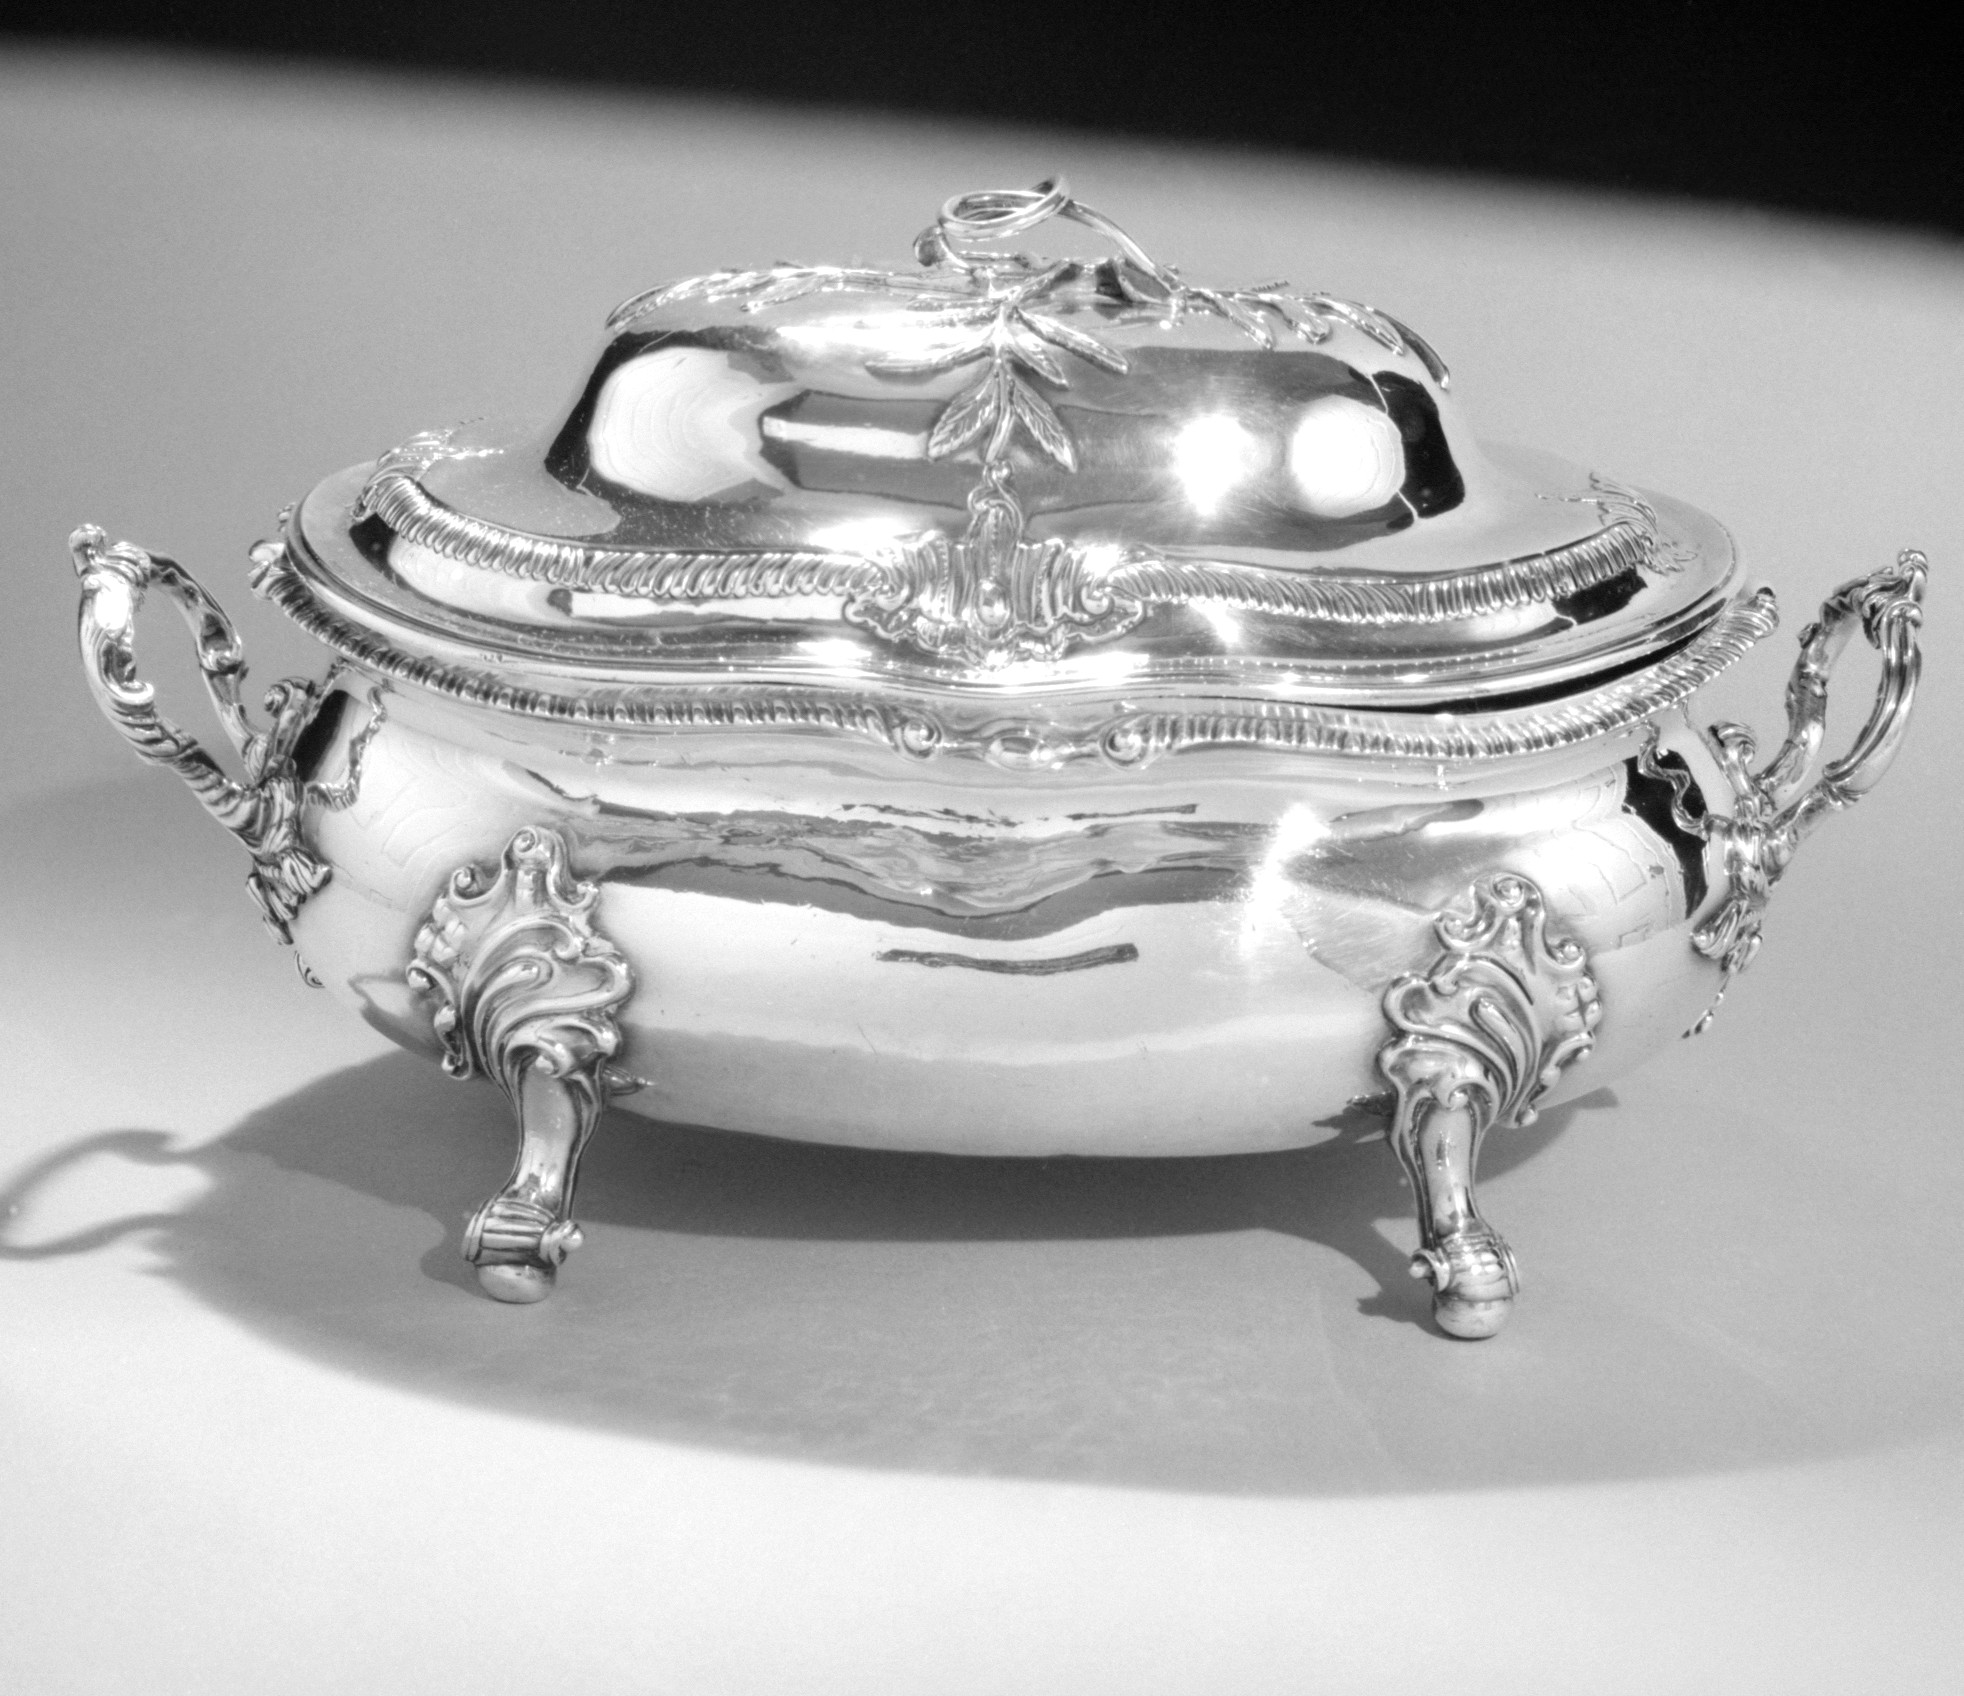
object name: tureen with cover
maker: william homer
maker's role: maker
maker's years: 1673-1773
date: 1701-1800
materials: silver